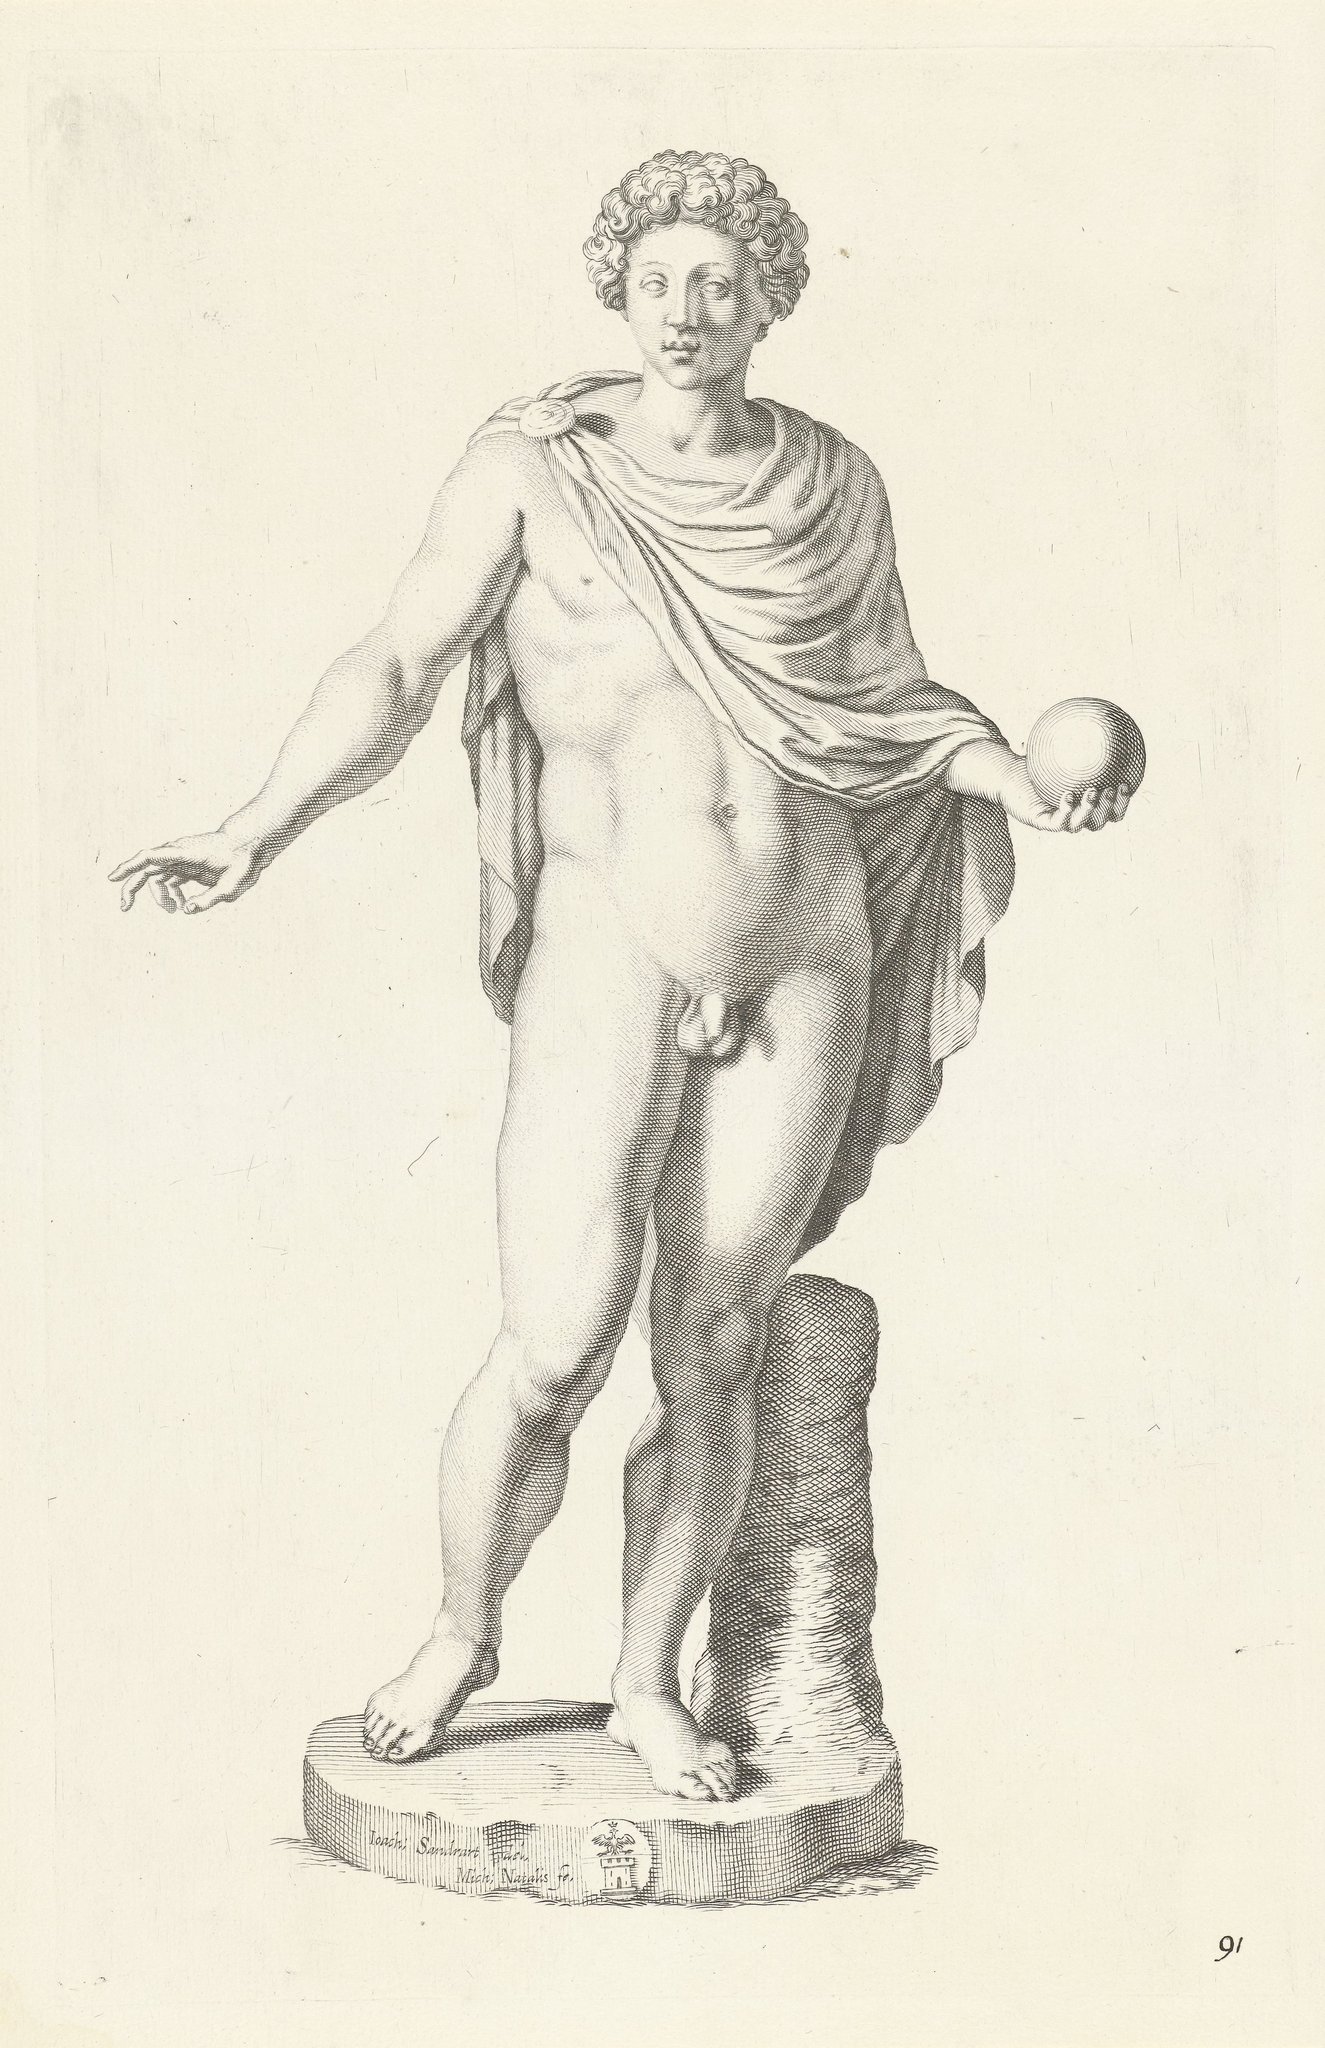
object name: print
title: Galleria Giustiniana del Marchese Vincenzo Giustiniani I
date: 1640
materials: paper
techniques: engraving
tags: rome, shot-putting, adult man, piece of sculpture, reproduction of a piece of sculpture, monument, statue, classical history (+ full length)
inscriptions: collector's mark: Lugt 2228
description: Standbeeld van de jonge Marcus Aurelius, een mantel over de schouders, met in zijn linkerhand een kogel. Midden onder op de basis het wapenschild van Vincenzo Giustiniani. Prent uit een serie naar de sculpturen in de verzameling in de Galleria Giustiniani te Rome.